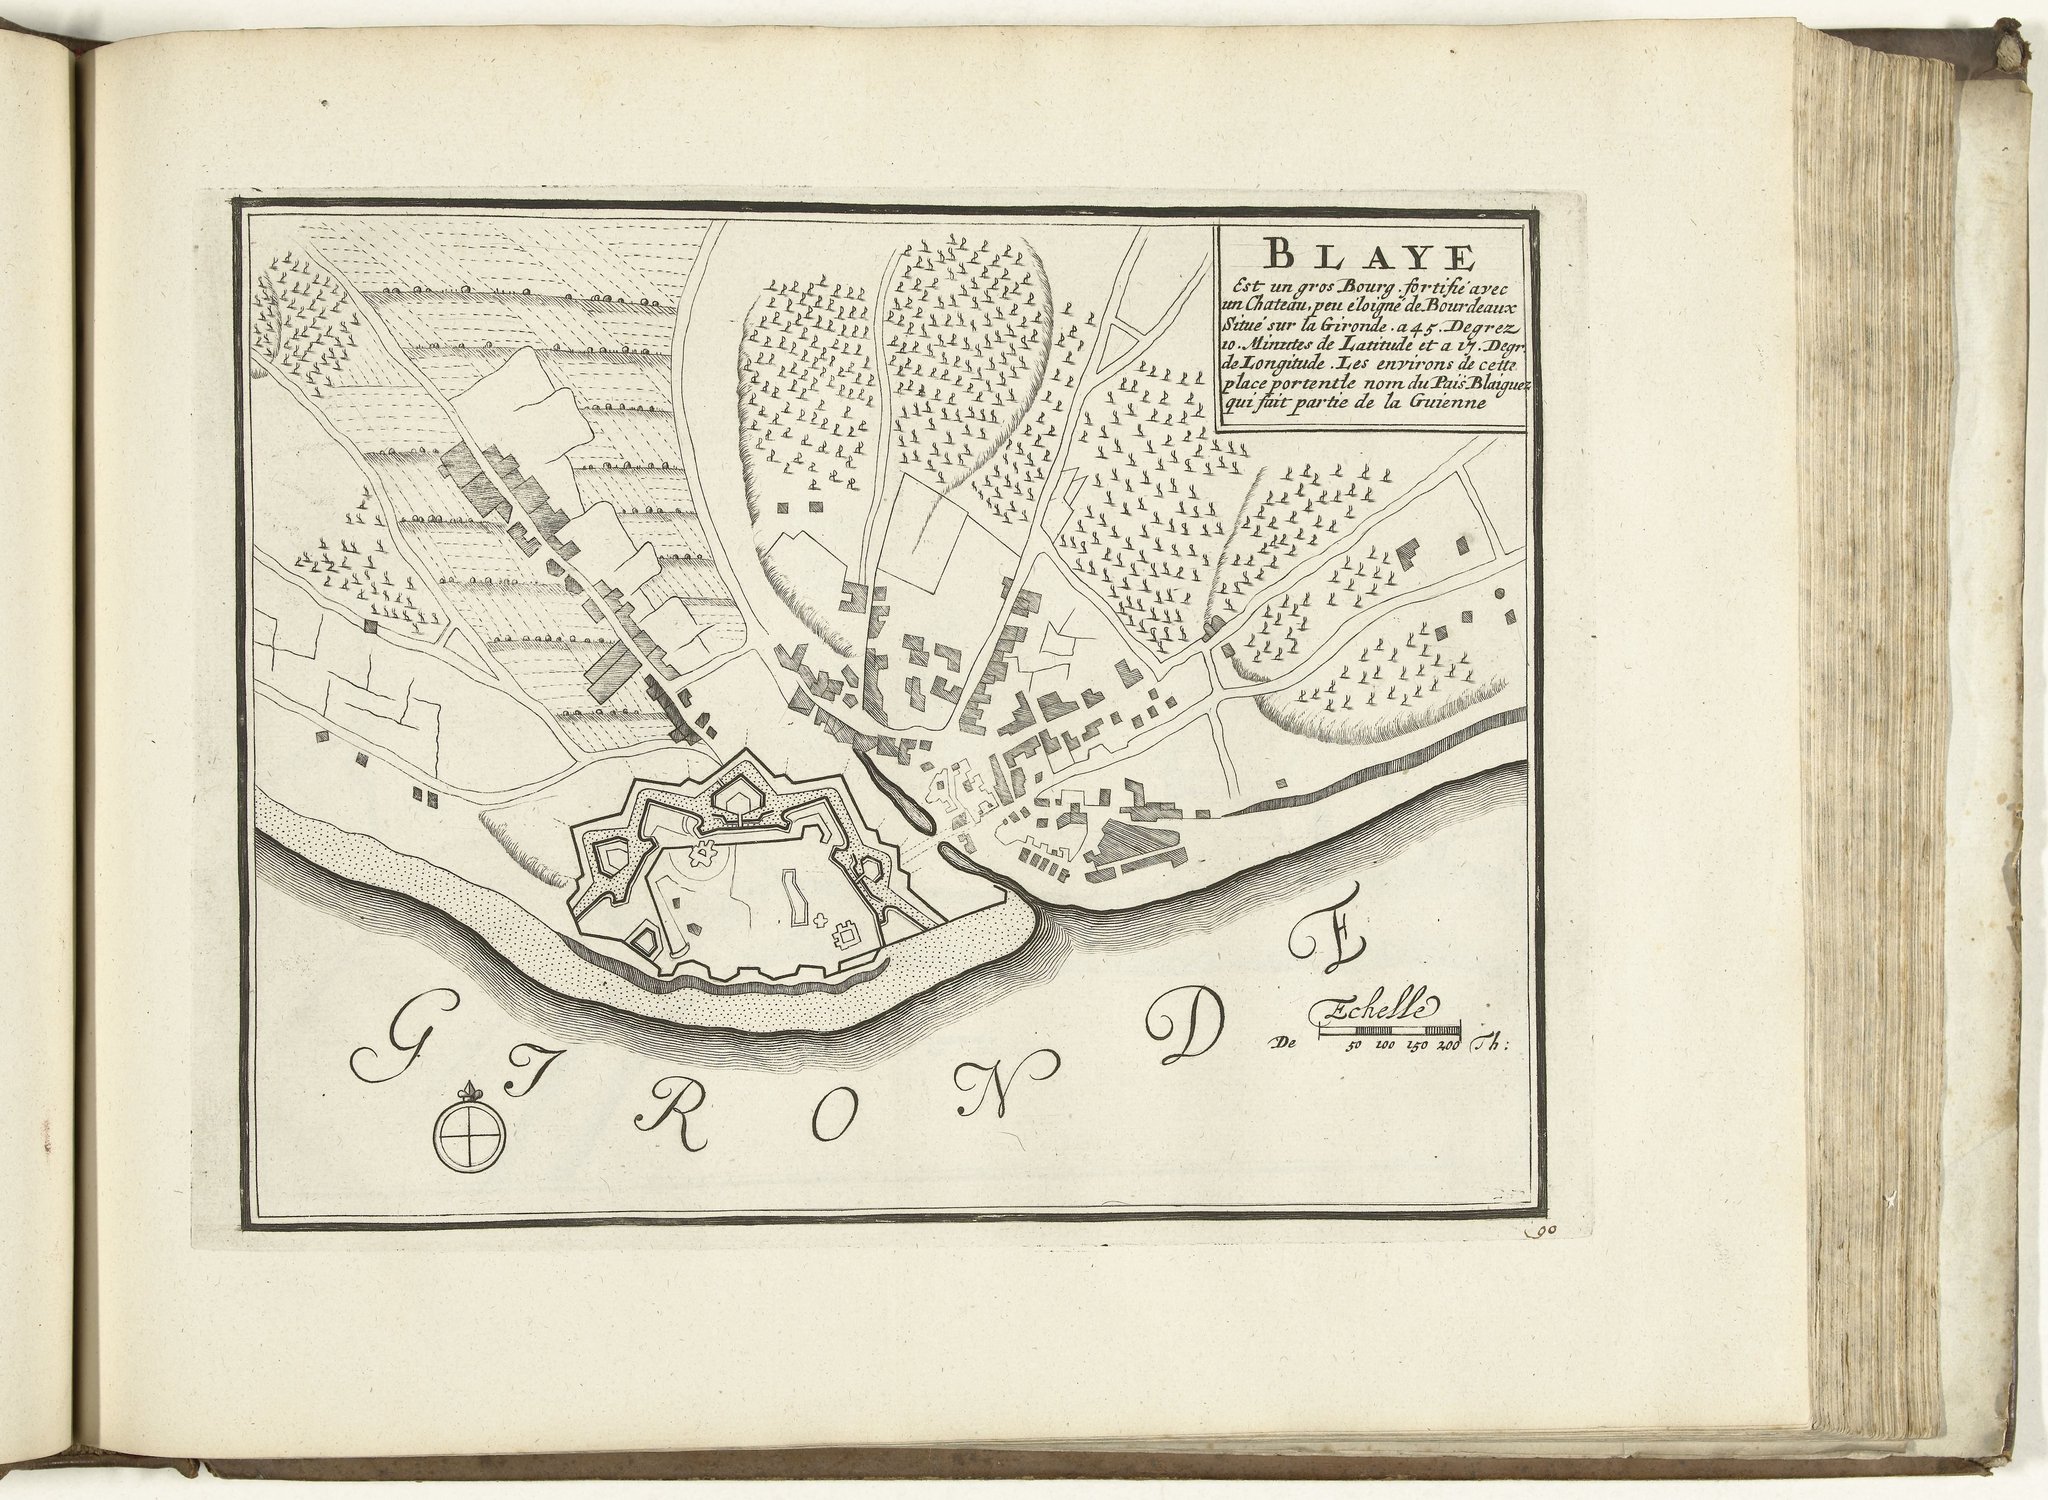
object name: print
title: Blaye Est un gros Bourg (...)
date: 1726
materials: paper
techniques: engraving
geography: northern netherlands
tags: fortress, maps of cities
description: Plattegrond van de versterkingen om de Franse stad Blaye. Plaat nr. 90 in deel IV van het prentwerk: Les Forces de l'Europe, Asie, Afrique et Amerique ... Comme aussi les Cartes des Côtes de France et d'Espagne uit 1726, dit eerste deel met 238 met de hand genummerde platen van vermaarde sterke steden en vestingen in het kader van de Spaanse Successieoorlog 1701-1713. Voor het merendeel zijn deze platen gekopieerd naar de anonieme Franse platen van vermaarde sterke steden en vestingen: in Les forces de l'Europe en in: Le theatre de la guerre, dans les Pays-Bas, beide oorspronkelijk uitgegeven door Nicolas de Fer te Parijs (1693-1697) in het kader van de Negenjarige Oorlog. Titel en opschriften in het Frans. Rechtsonder sporen van het weggepolijste nummer: 250.